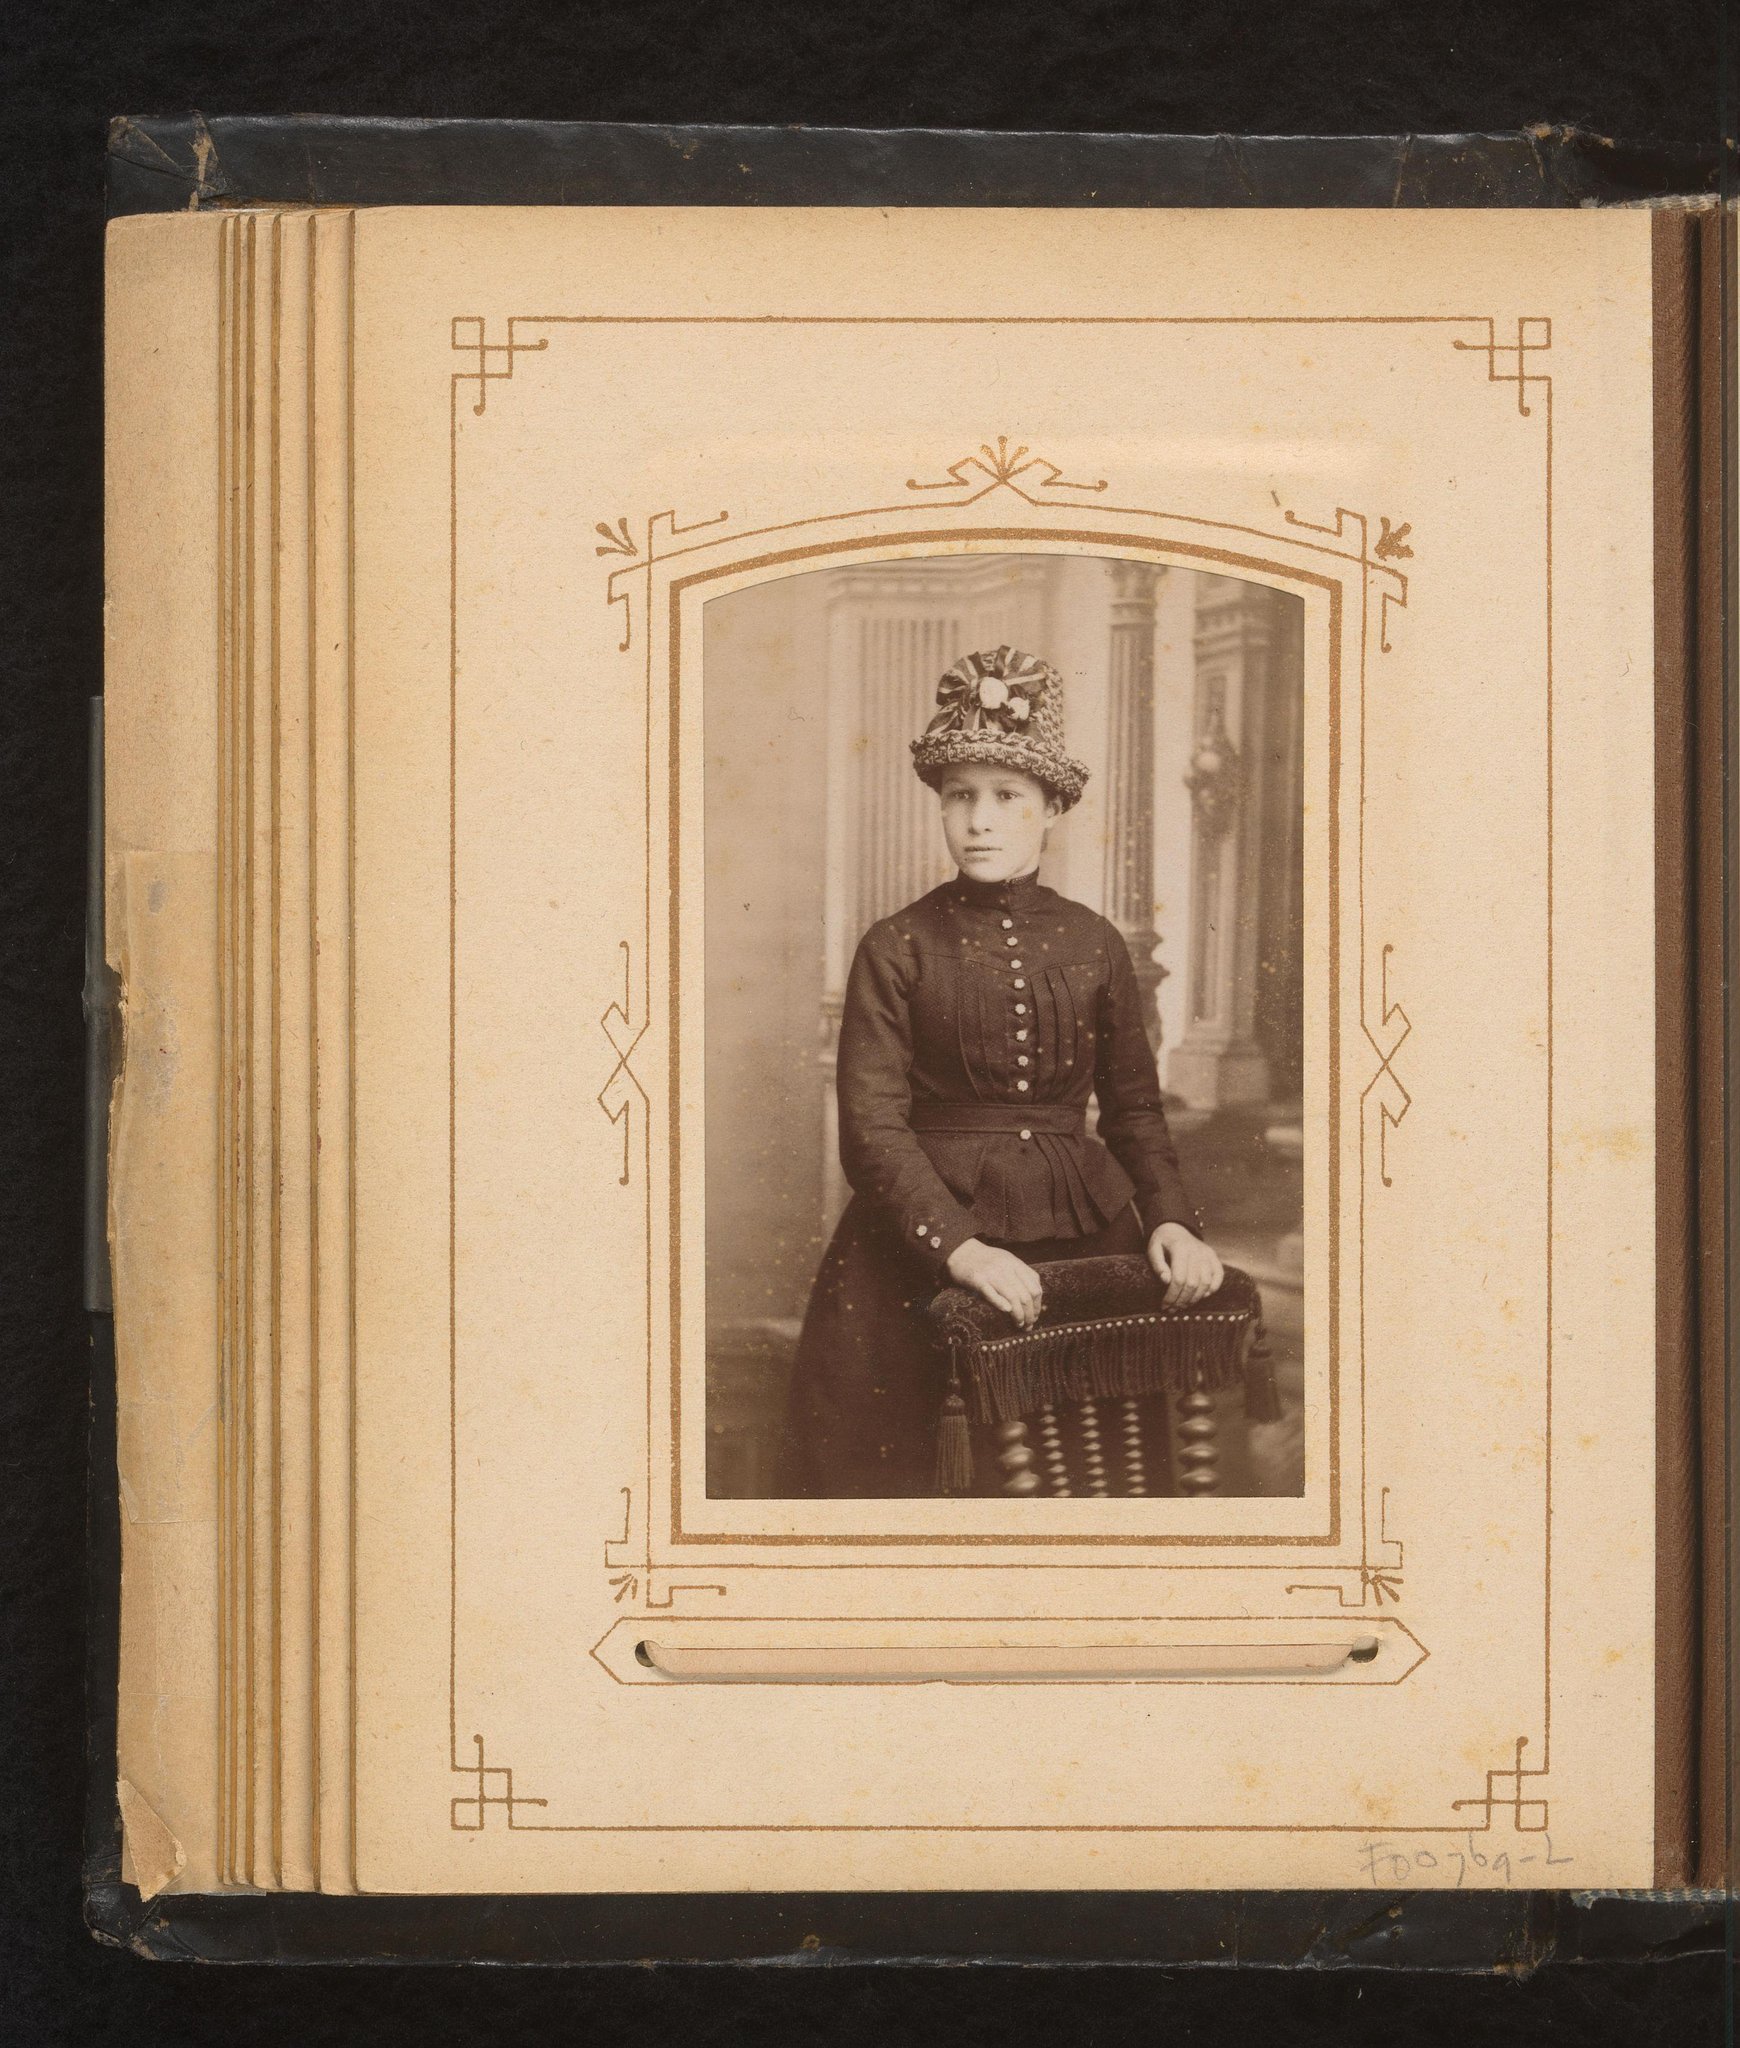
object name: album leaf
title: Portret van een vrouw met hoed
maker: robert ruegg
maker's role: fotograaf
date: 1870-1900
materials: cardboard, photographic support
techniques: albumen print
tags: adult woman, head-gear, historical persons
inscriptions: inscription: ‘Photographie/ Robert Ruegg/ Badstrasse No. 516/ Baden/ Schweiz (...)’